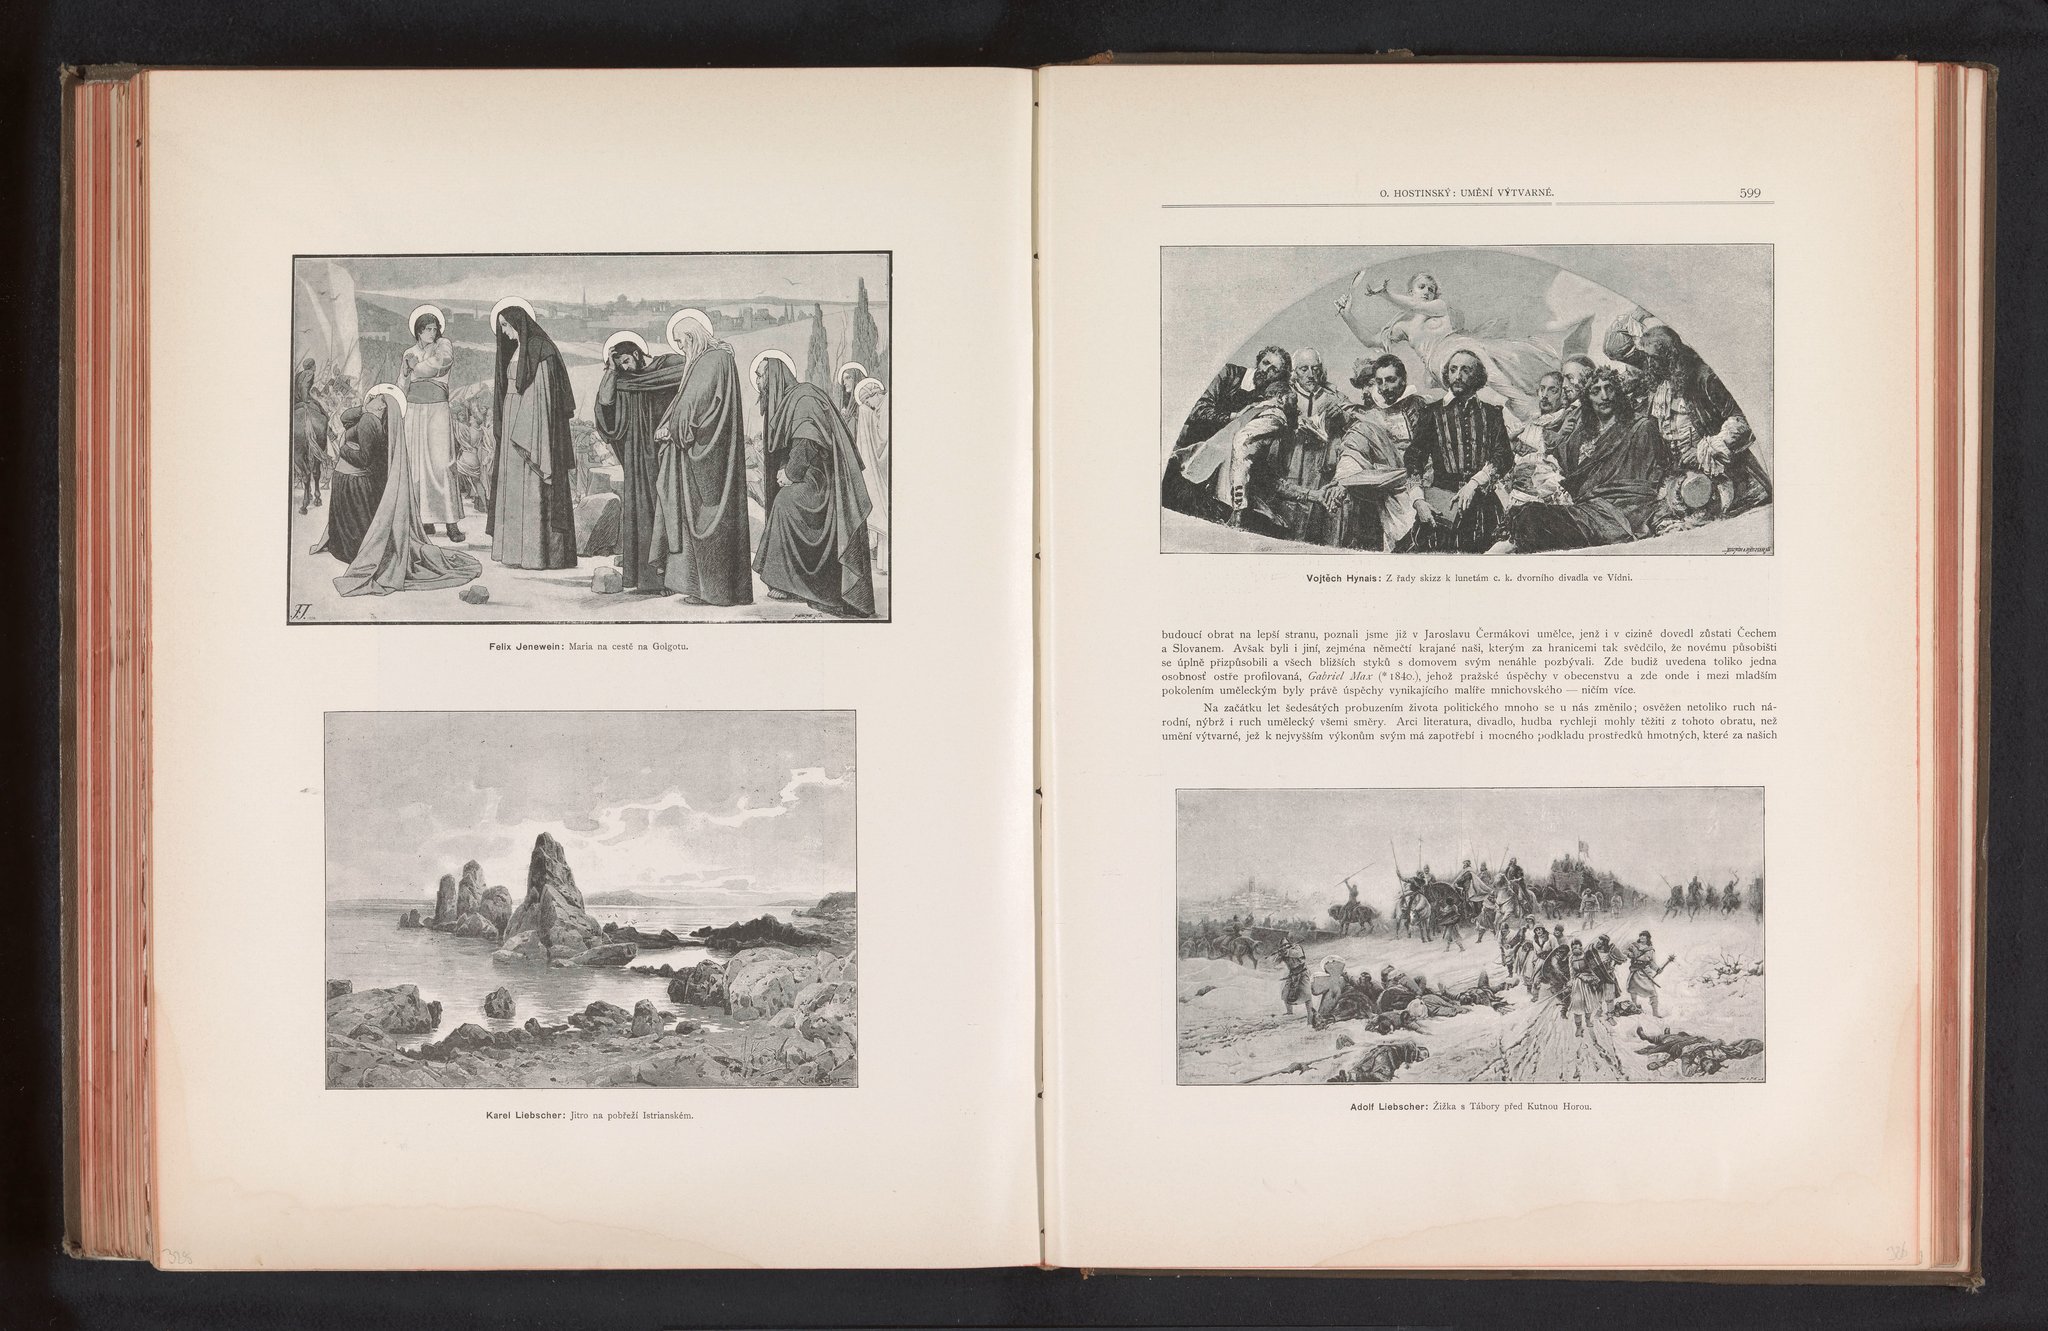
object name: page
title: Vojtech Hynais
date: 1891-1895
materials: paper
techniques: autotype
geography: prague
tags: honouring the artist with laurel wreath, battle